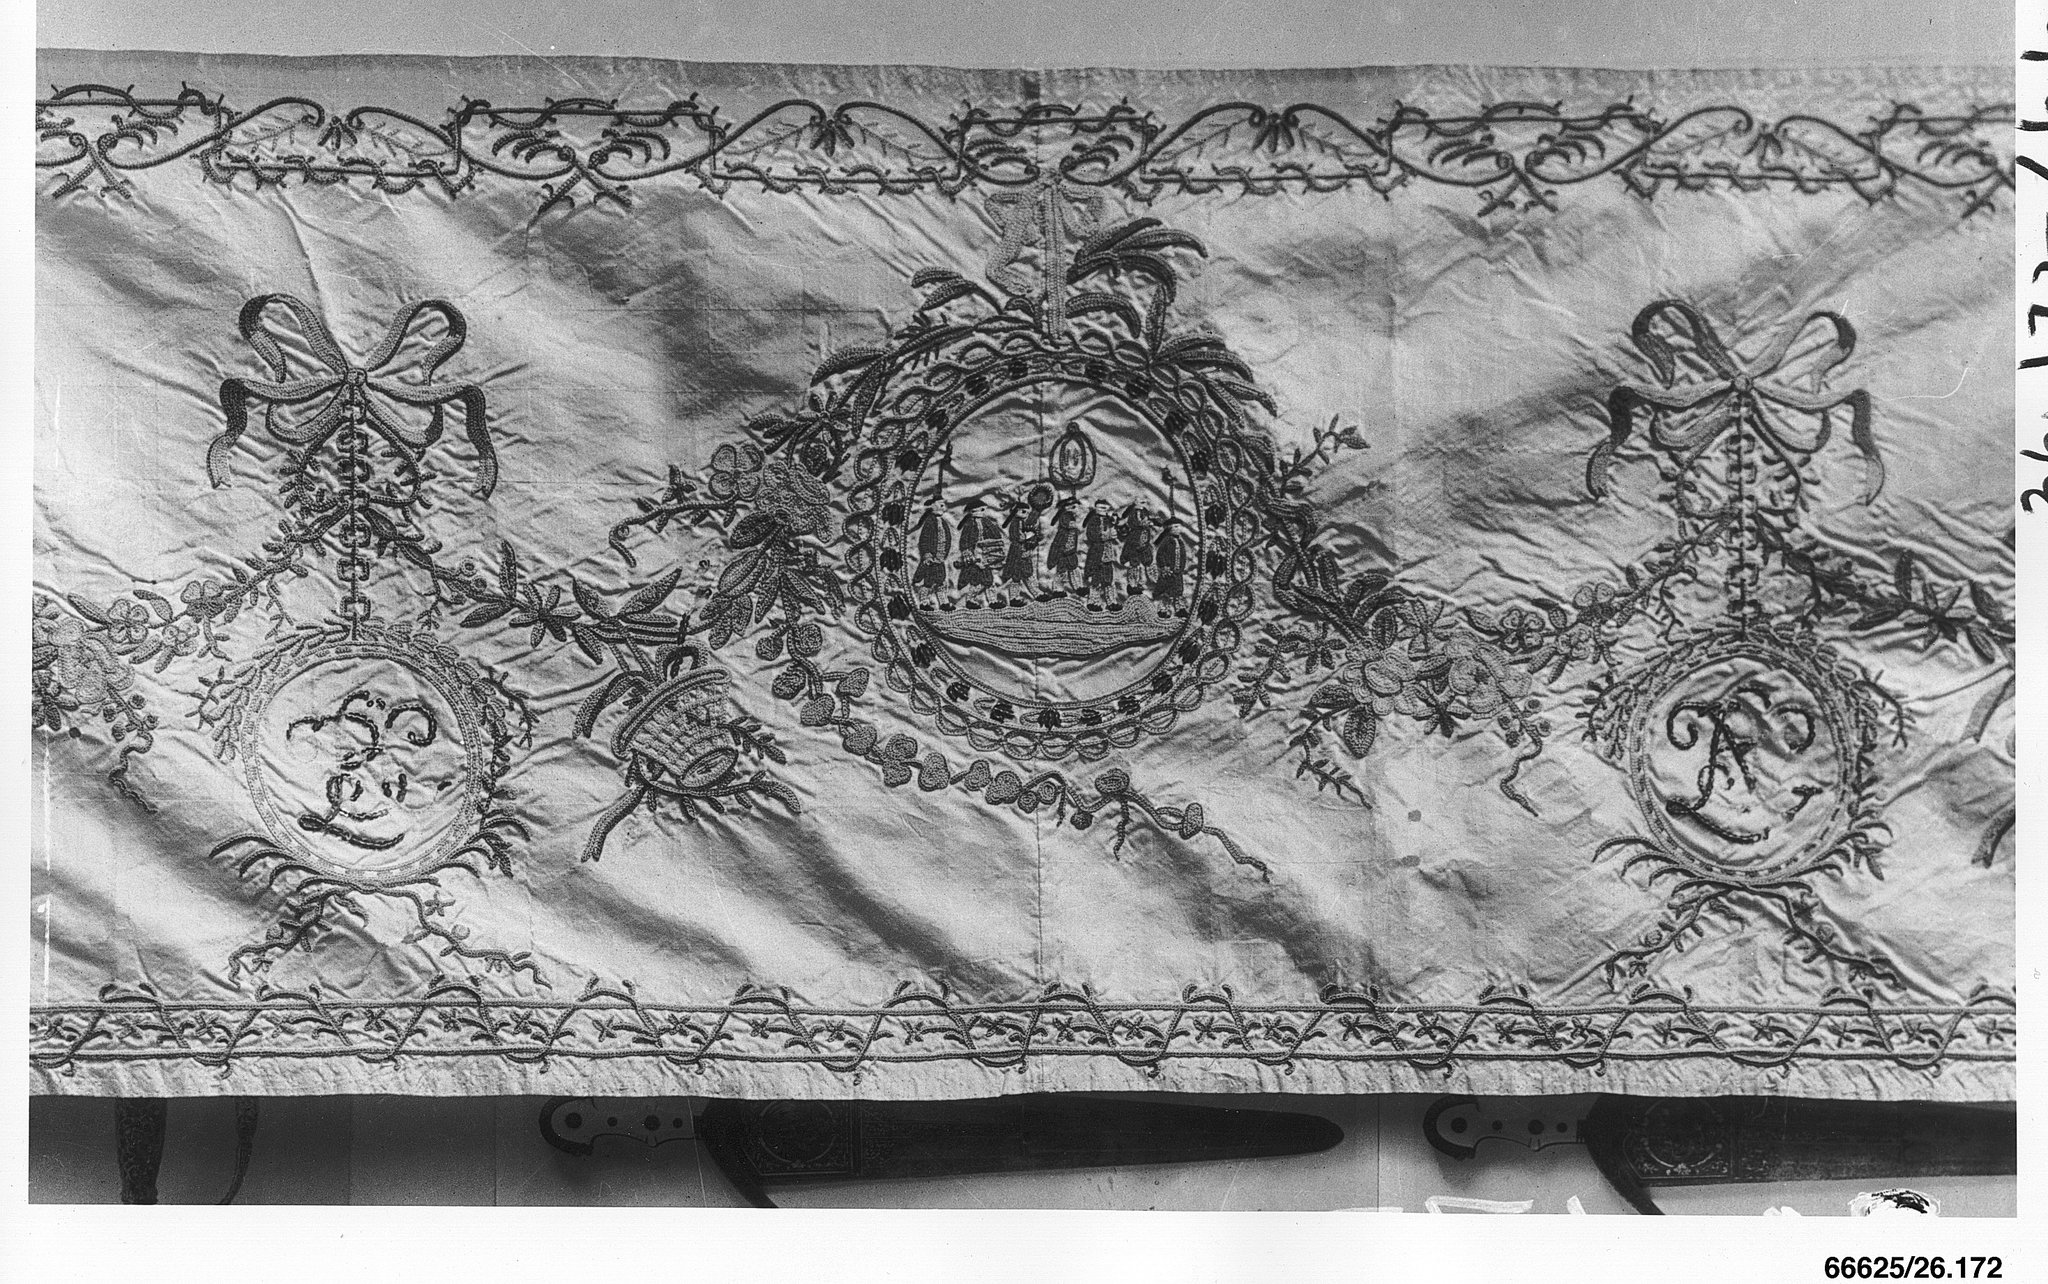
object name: panel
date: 1767-1800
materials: silk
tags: men,flowers